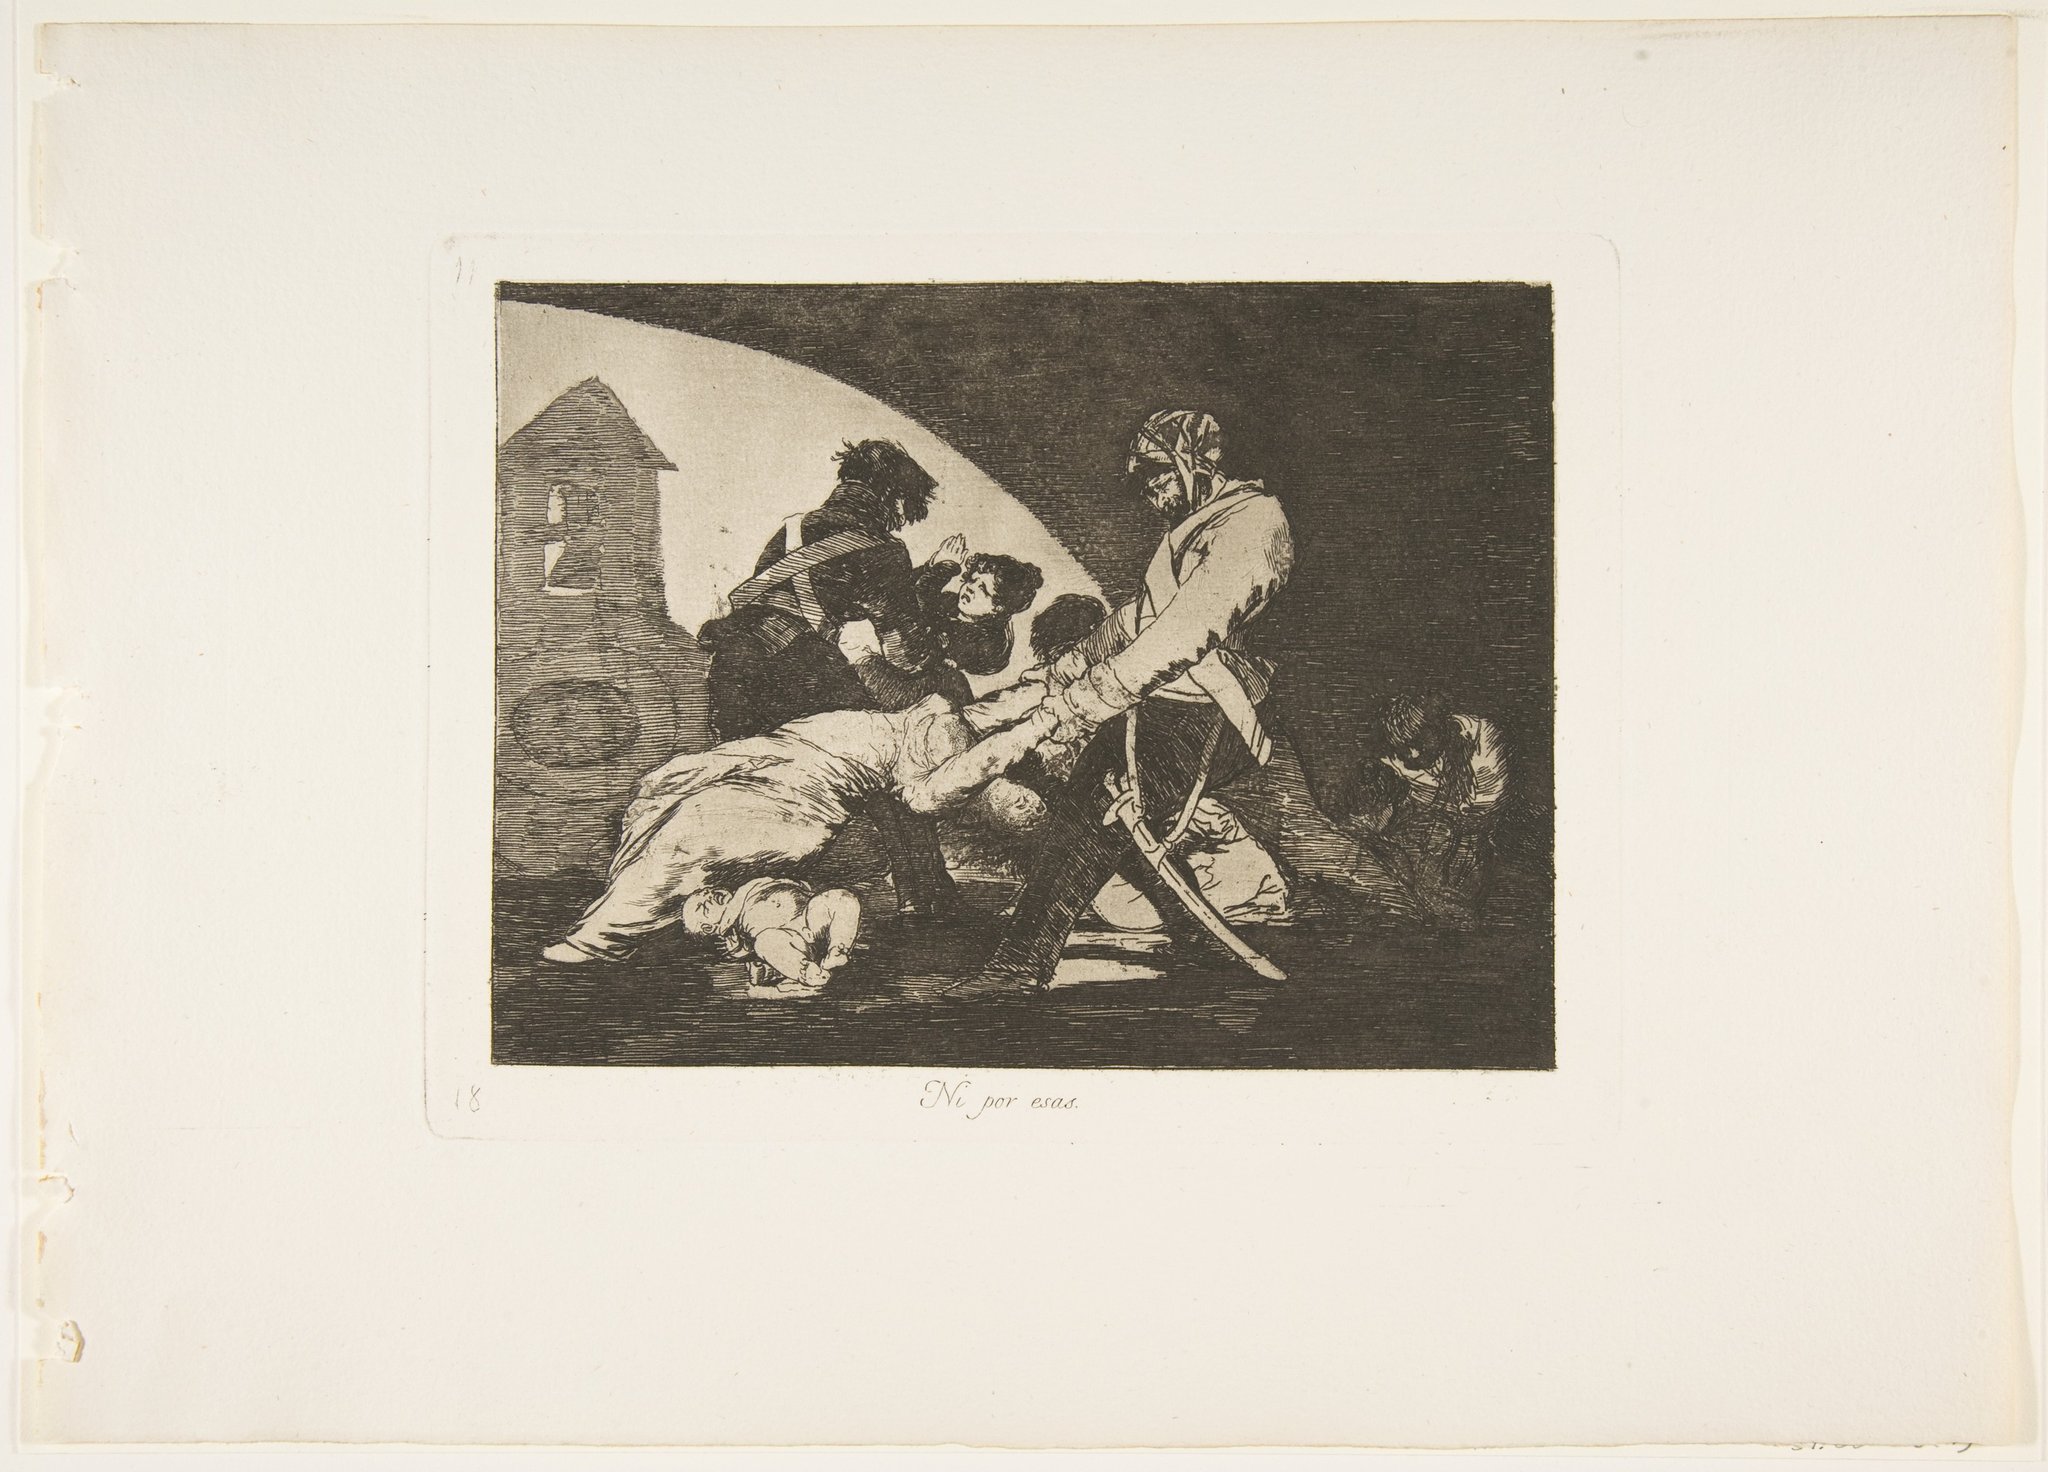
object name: print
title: Plate 11 from "The Disasters of War" (Los Desastres de la Guerra): Not even in that way (Ni por esas)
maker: goya (francisco de goya y lucientes)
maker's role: artist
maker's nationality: spanish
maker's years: 1746-1828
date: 1810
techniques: engraving, drypoint, etching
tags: infants,men,women